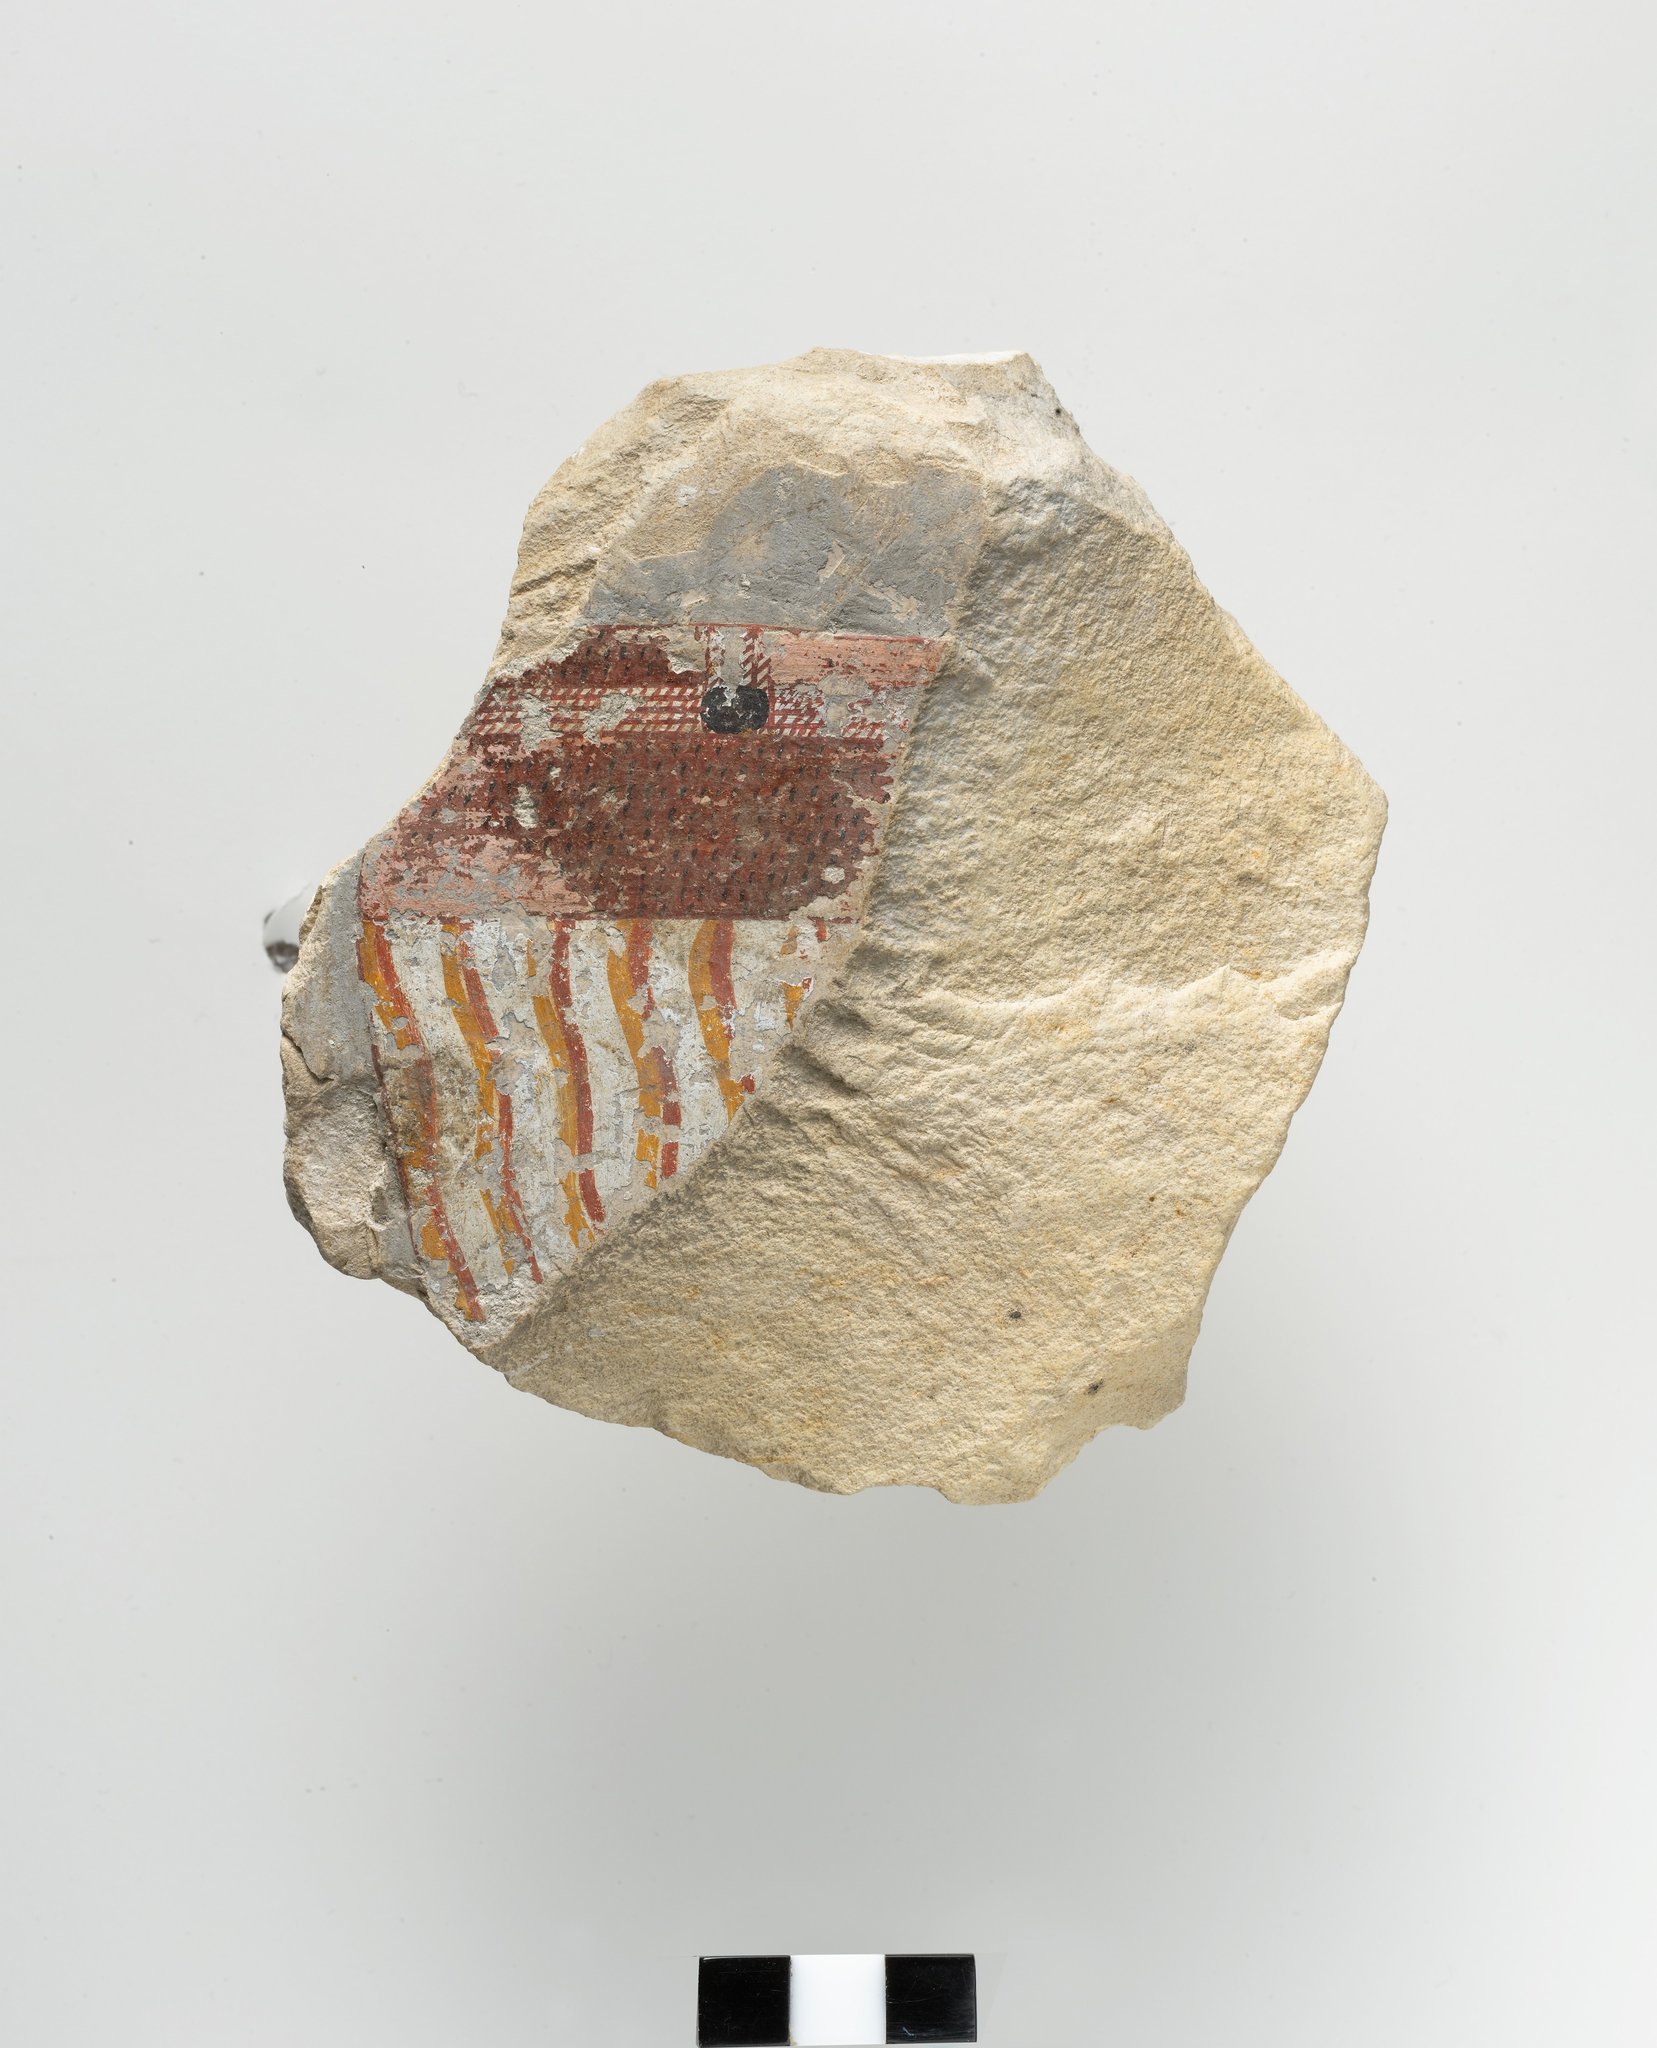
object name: relief fragment, tomb of meketre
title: Relief fragments from tomb of Meketre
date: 1981-1975 BCE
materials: limestone, paint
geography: egypt